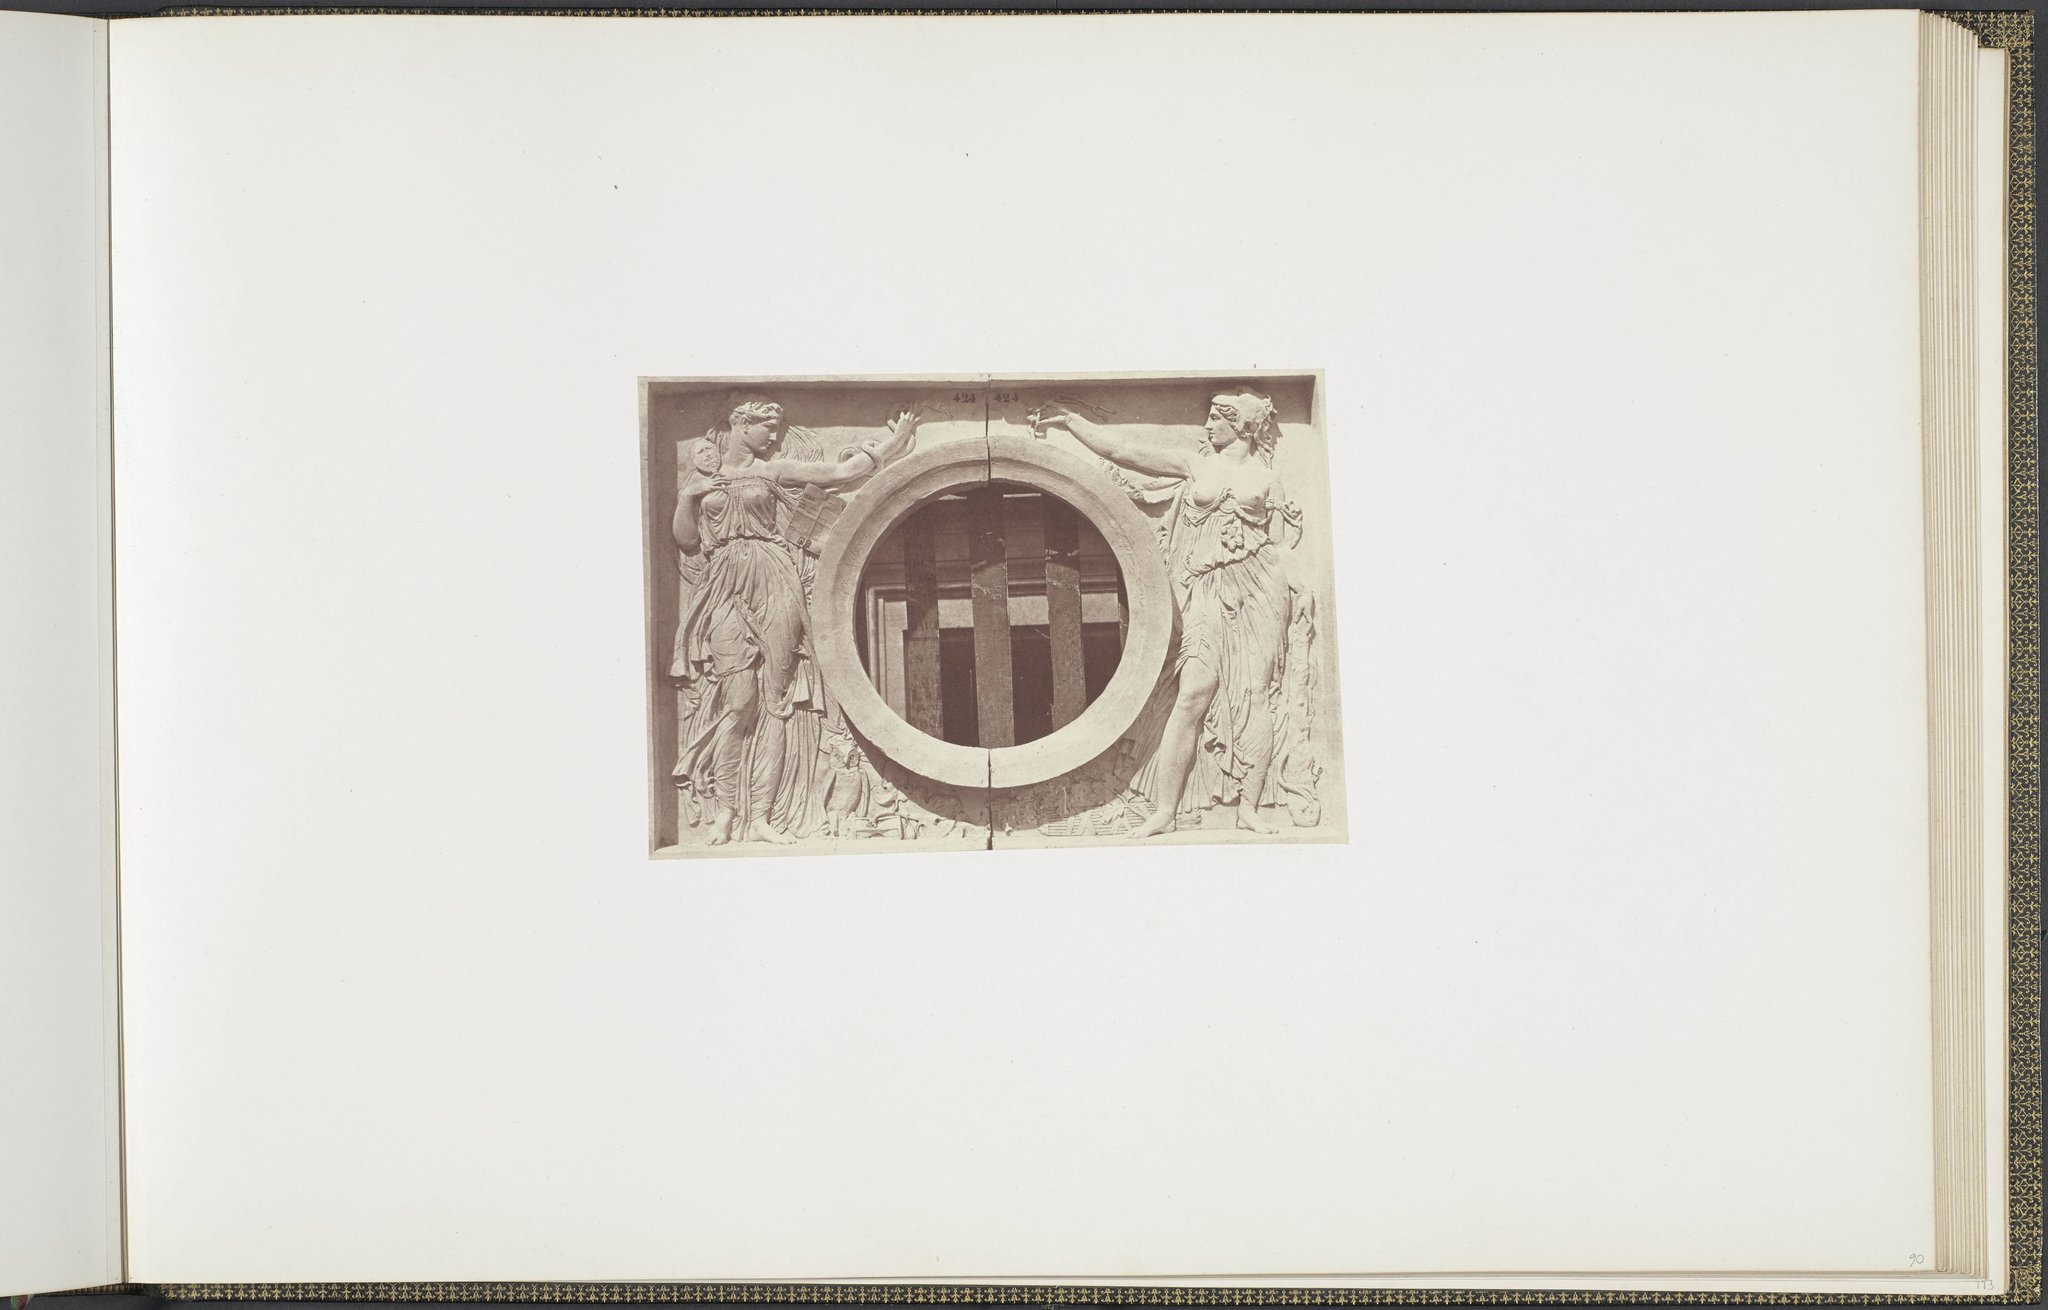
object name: album leaf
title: Gipsmodellen voor beeldhouwwerken op het Palais du Louvre: "La Prudence et la Force" door Joseph Félon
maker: édouard denis baldus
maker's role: fotograaf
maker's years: 1813-1889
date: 1855-1857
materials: paper, photographic support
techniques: salted paper print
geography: paris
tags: piece of sculpture, reproduction of a piece of sculpture, permanent exhibition, museum, paris, tuileries palace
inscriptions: number: ‘424’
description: Onderdeel van Réunion des Tuileries au Louvre 1852-1857, album 1.